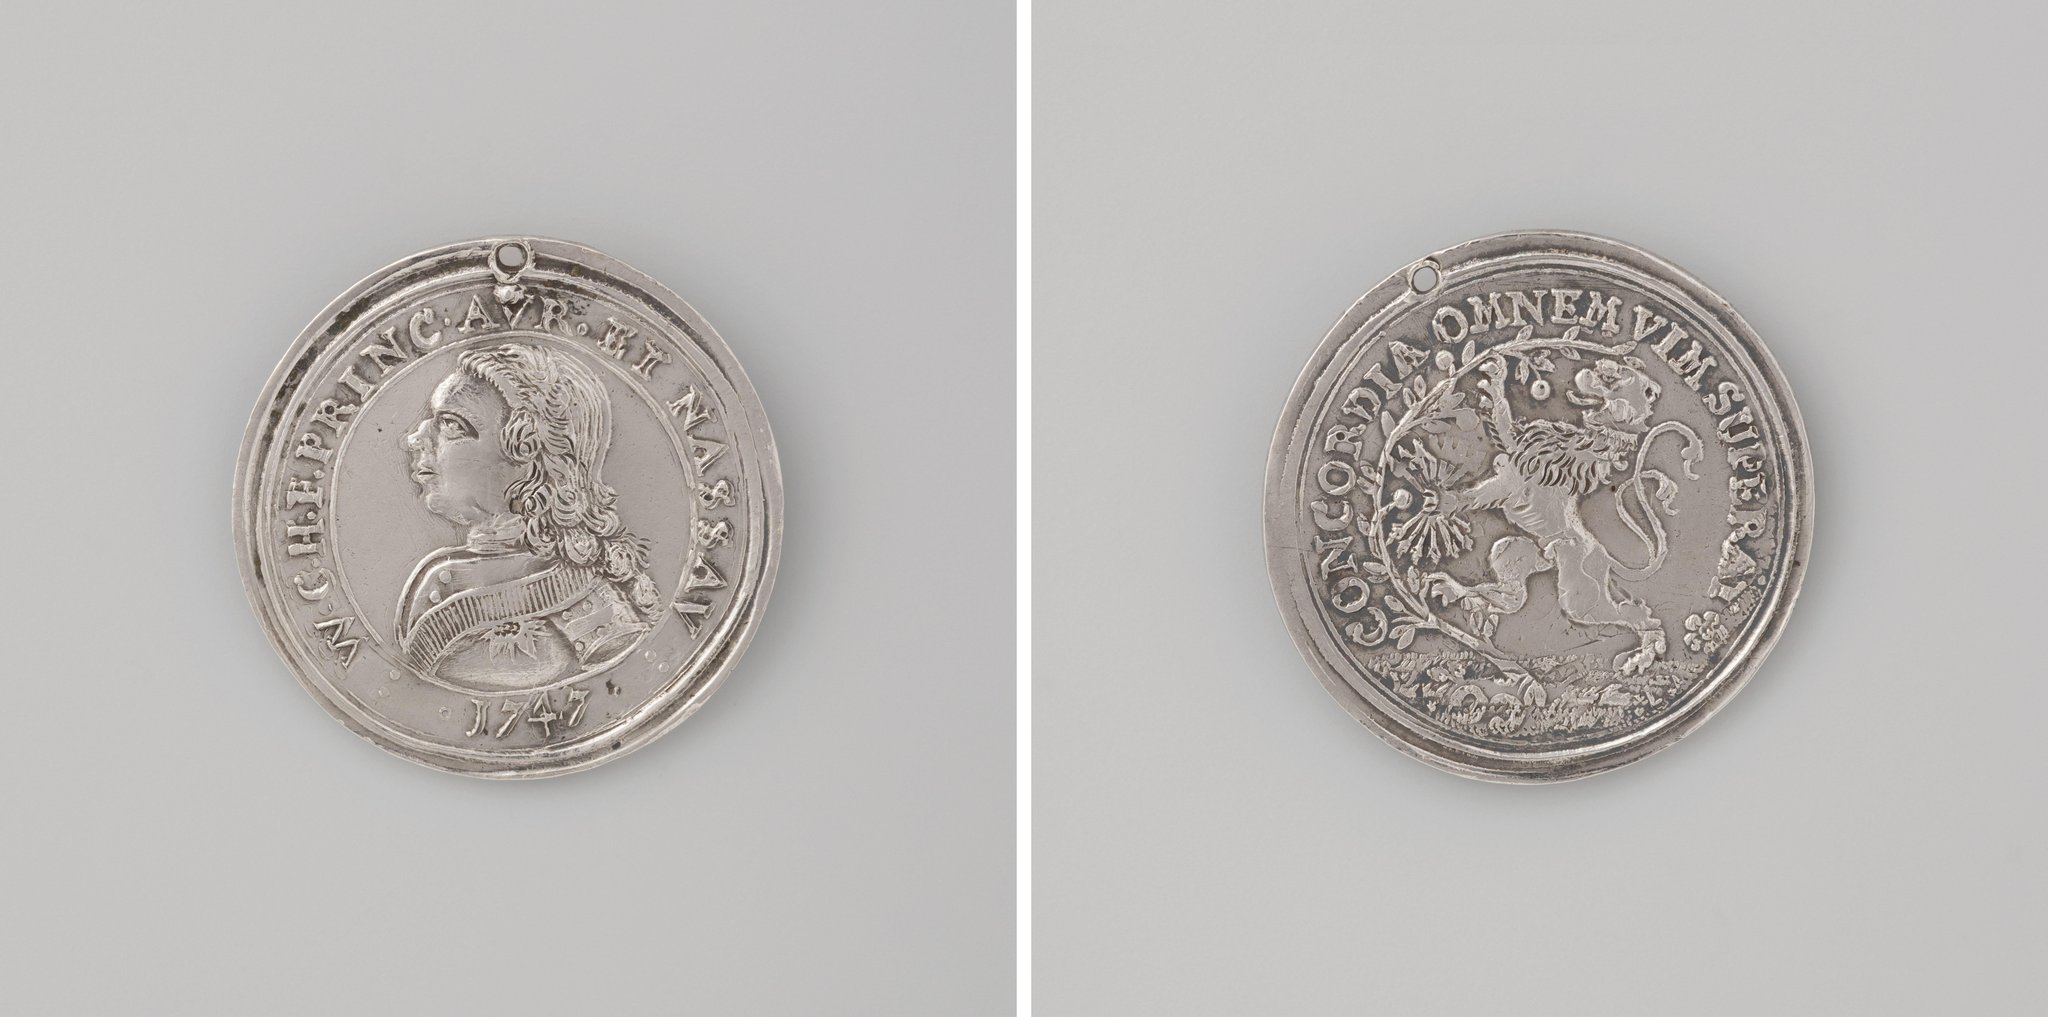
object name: history medal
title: Verheffing van de prins van Oranje tot stadhouder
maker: Anonymous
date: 1747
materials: silver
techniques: striking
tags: the hague, willem iv (prins van oranje-nassau)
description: Zilveren penning met gat erin. Voorzijde: borststuk man binnen omschrift. Keerzijde: leeuw met pijlenbundel houdt oranjetak in klauw binnen omschrift